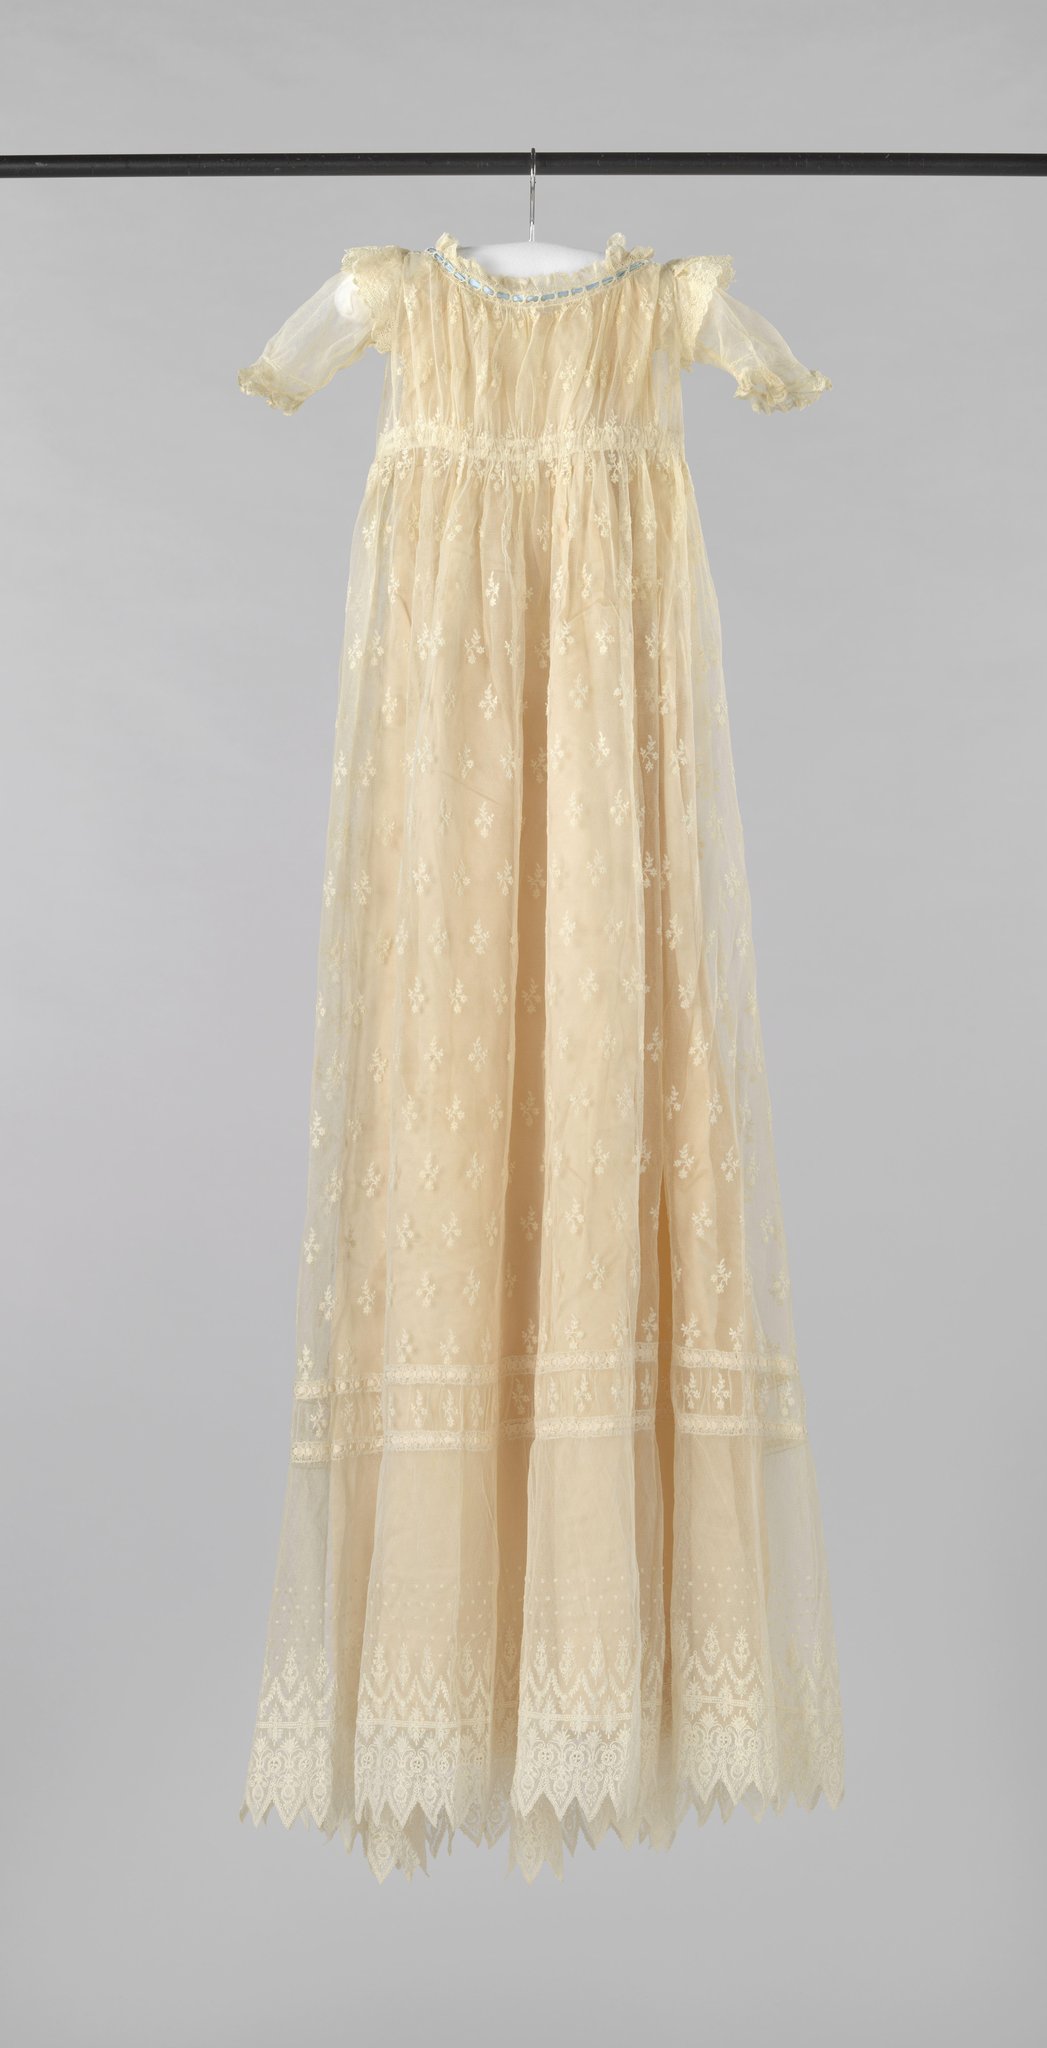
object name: ribbon material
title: Beige lint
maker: Anonymous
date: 1850-1920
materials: silk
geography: netherlands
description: Beige lint behorende bij doopjurk met tuledoorstop en onderjurk van zijde. Door de hals is een blauw lint geregen, rond het middel twee beige linten.